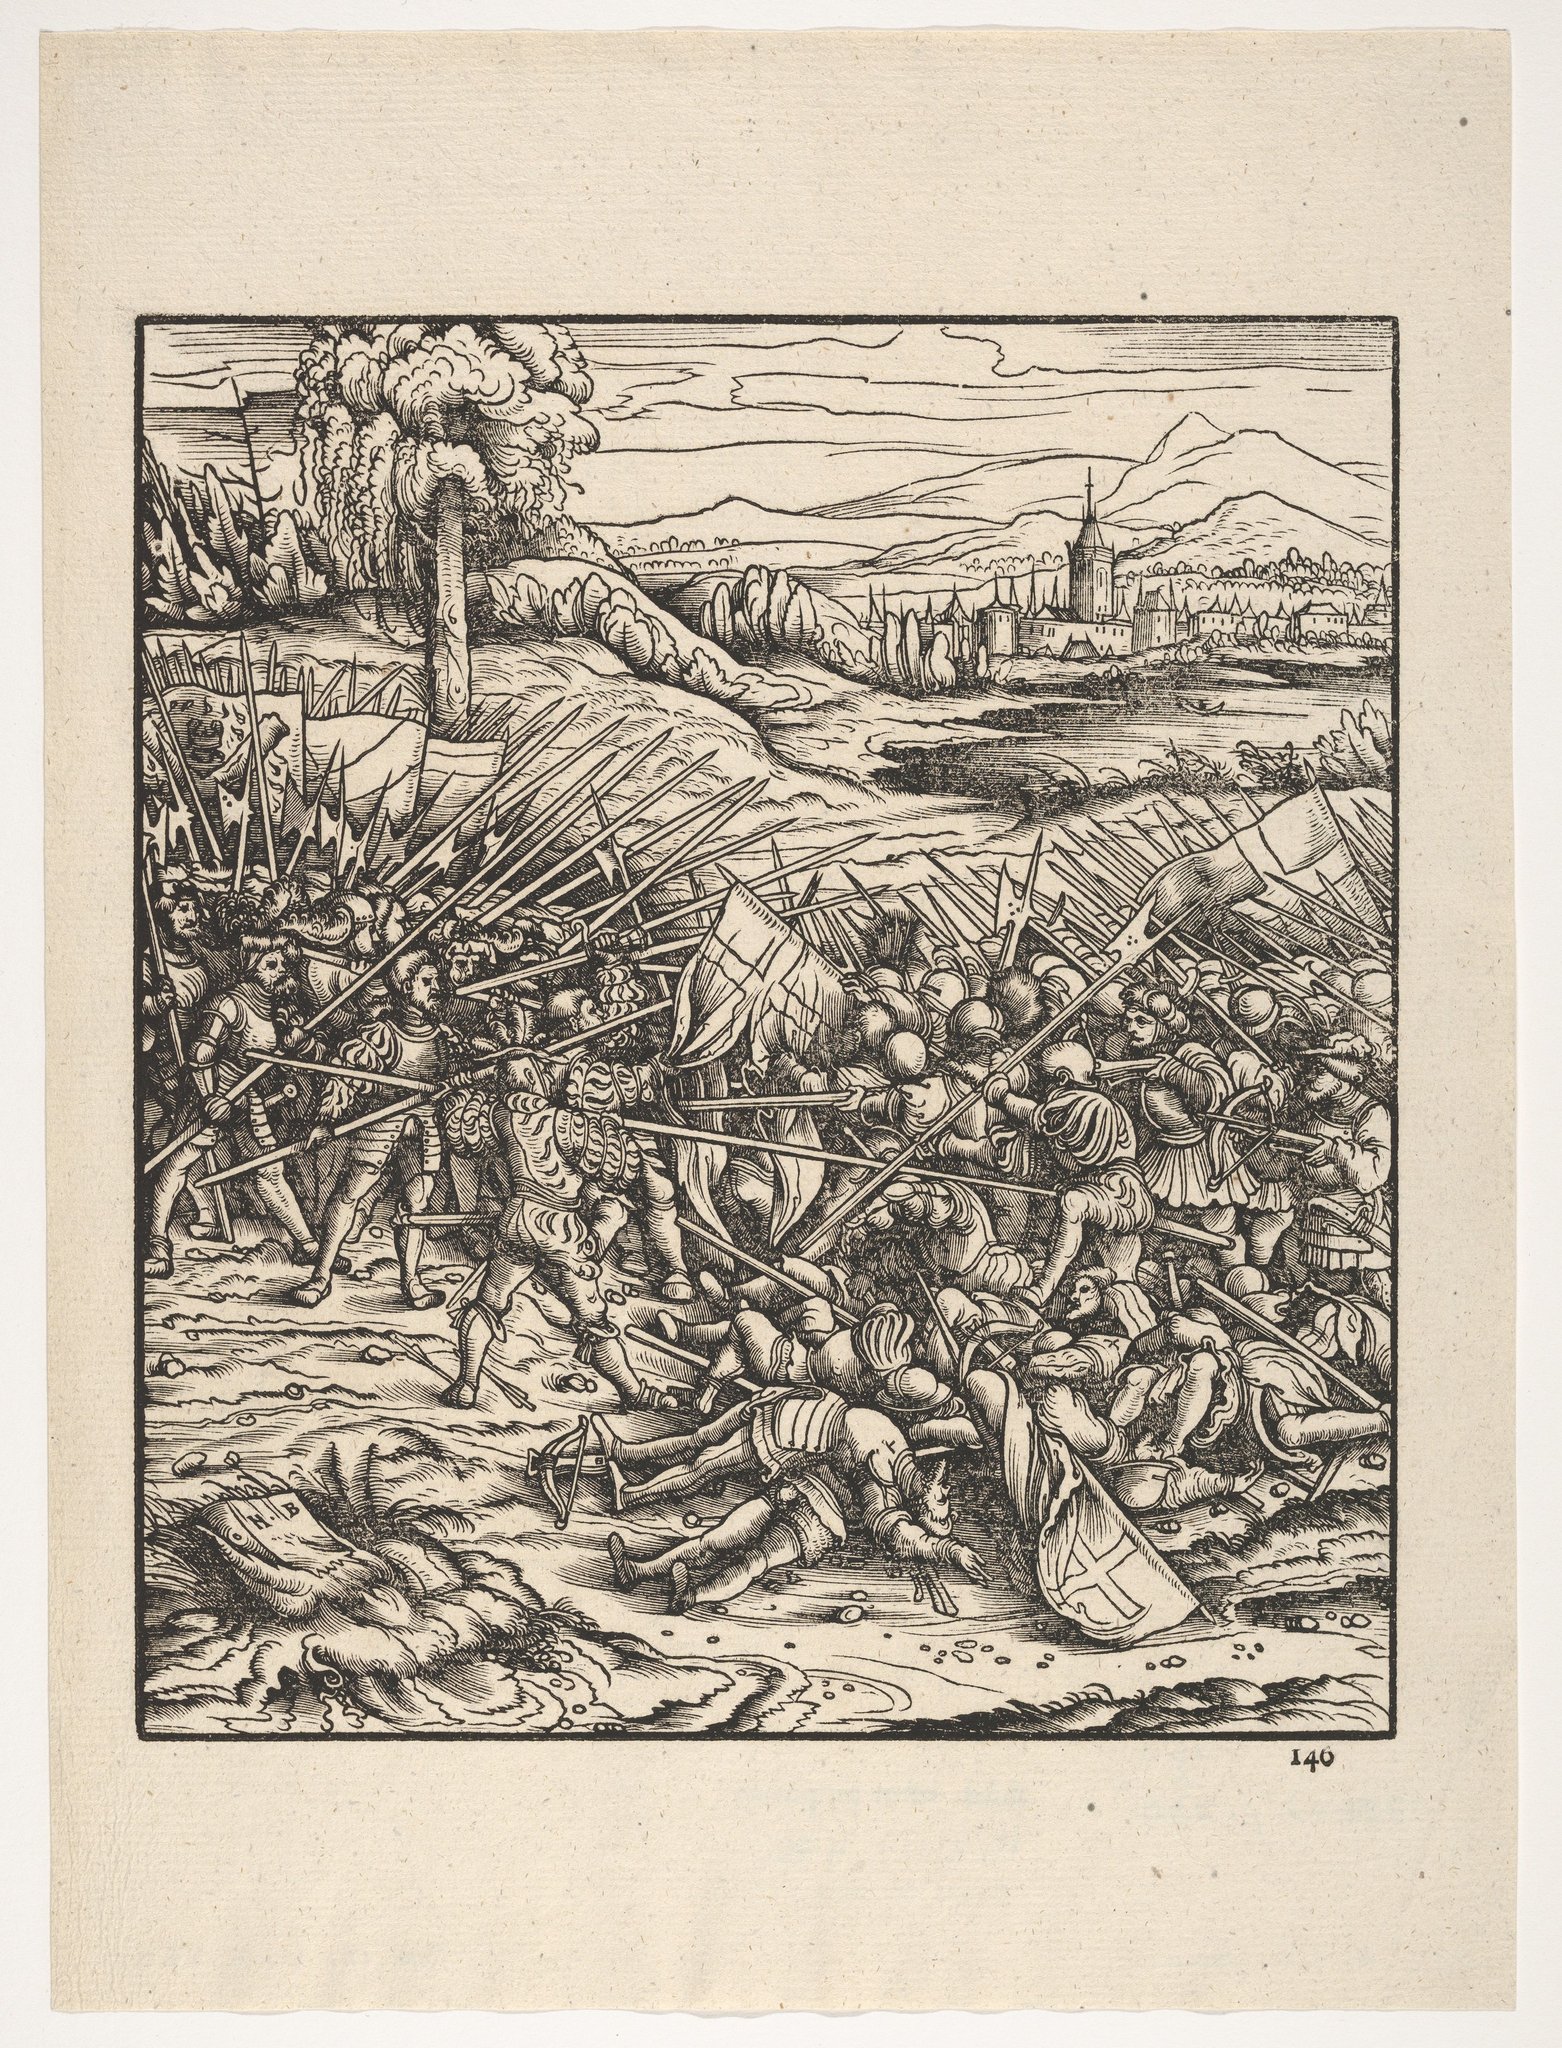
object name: print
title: The Battle Near Hulst, from "Der Weisskunig"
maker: hans burgkmair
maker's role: artist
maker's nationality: german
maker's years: 1473-1531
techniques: woodcut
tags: battles,soldiers,weapons,flags